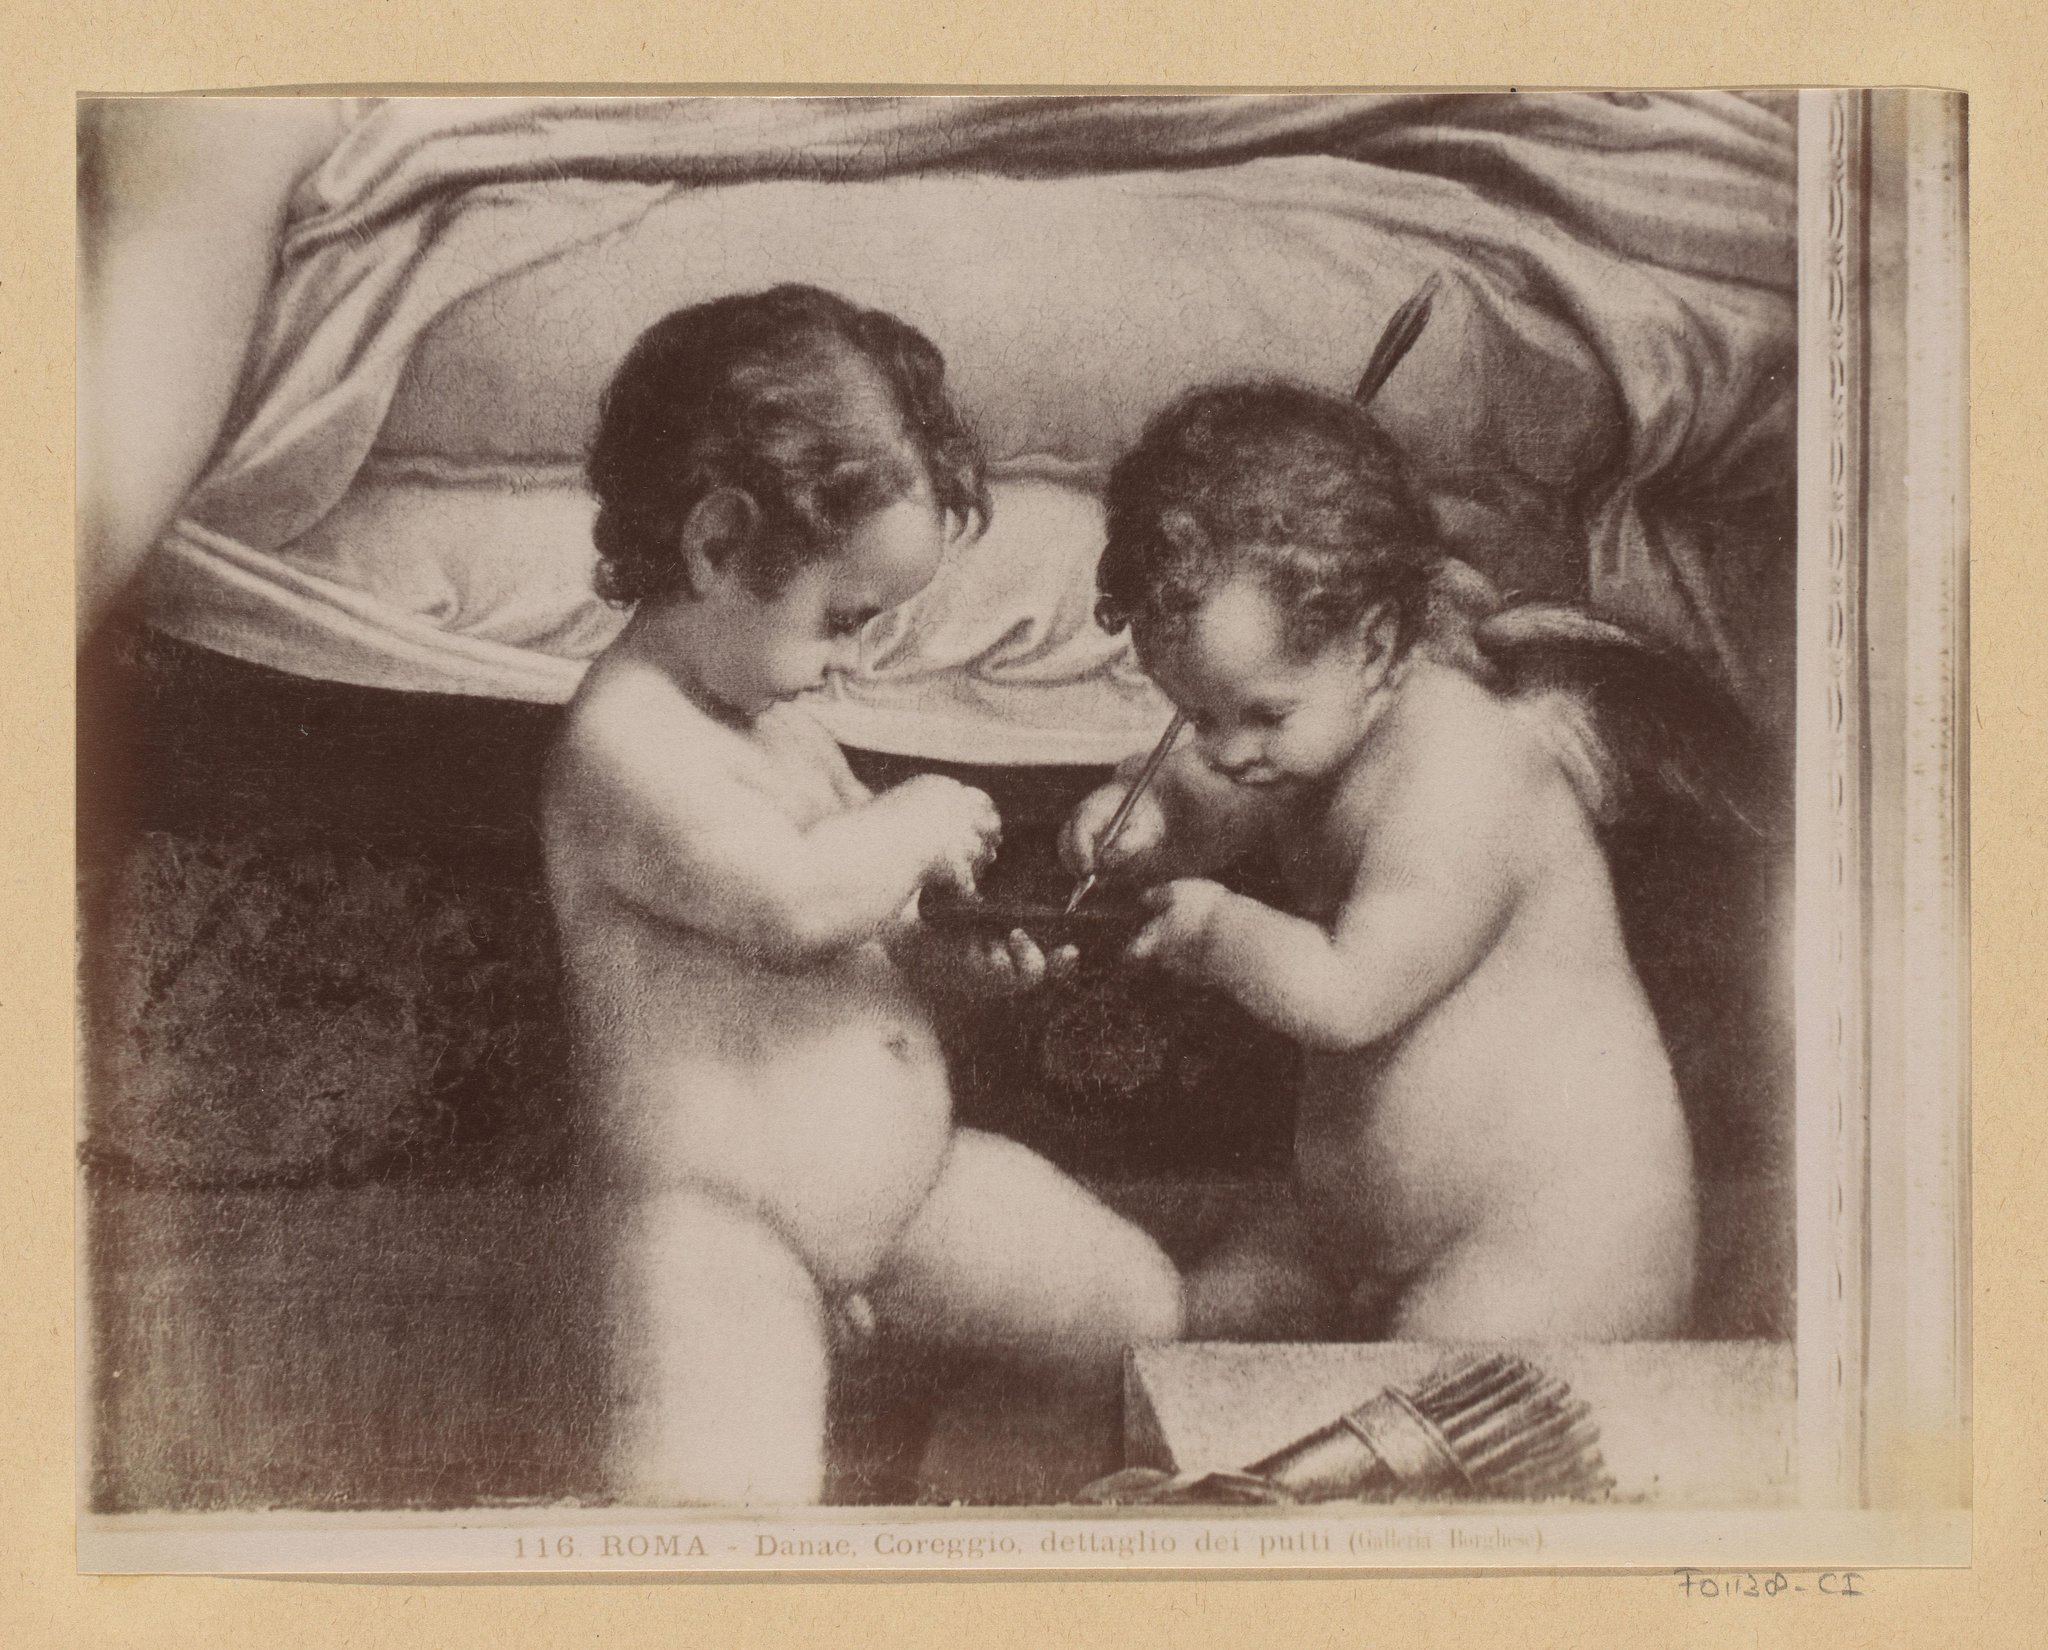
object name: reproduction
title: Danae, Coreggio, dettaglio dei putti (Galleria Borghese)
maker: Anonymous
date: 1860-1900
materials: photographic support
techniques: albumen print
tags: cupids: 'amores', 'amoretti', 'putti'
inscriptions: number: ‘116’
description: Onderdeel van Reisalbum met opnames van kunstwerken en bezienswaardigheden in Italië, Griekenland en Frankrijk.